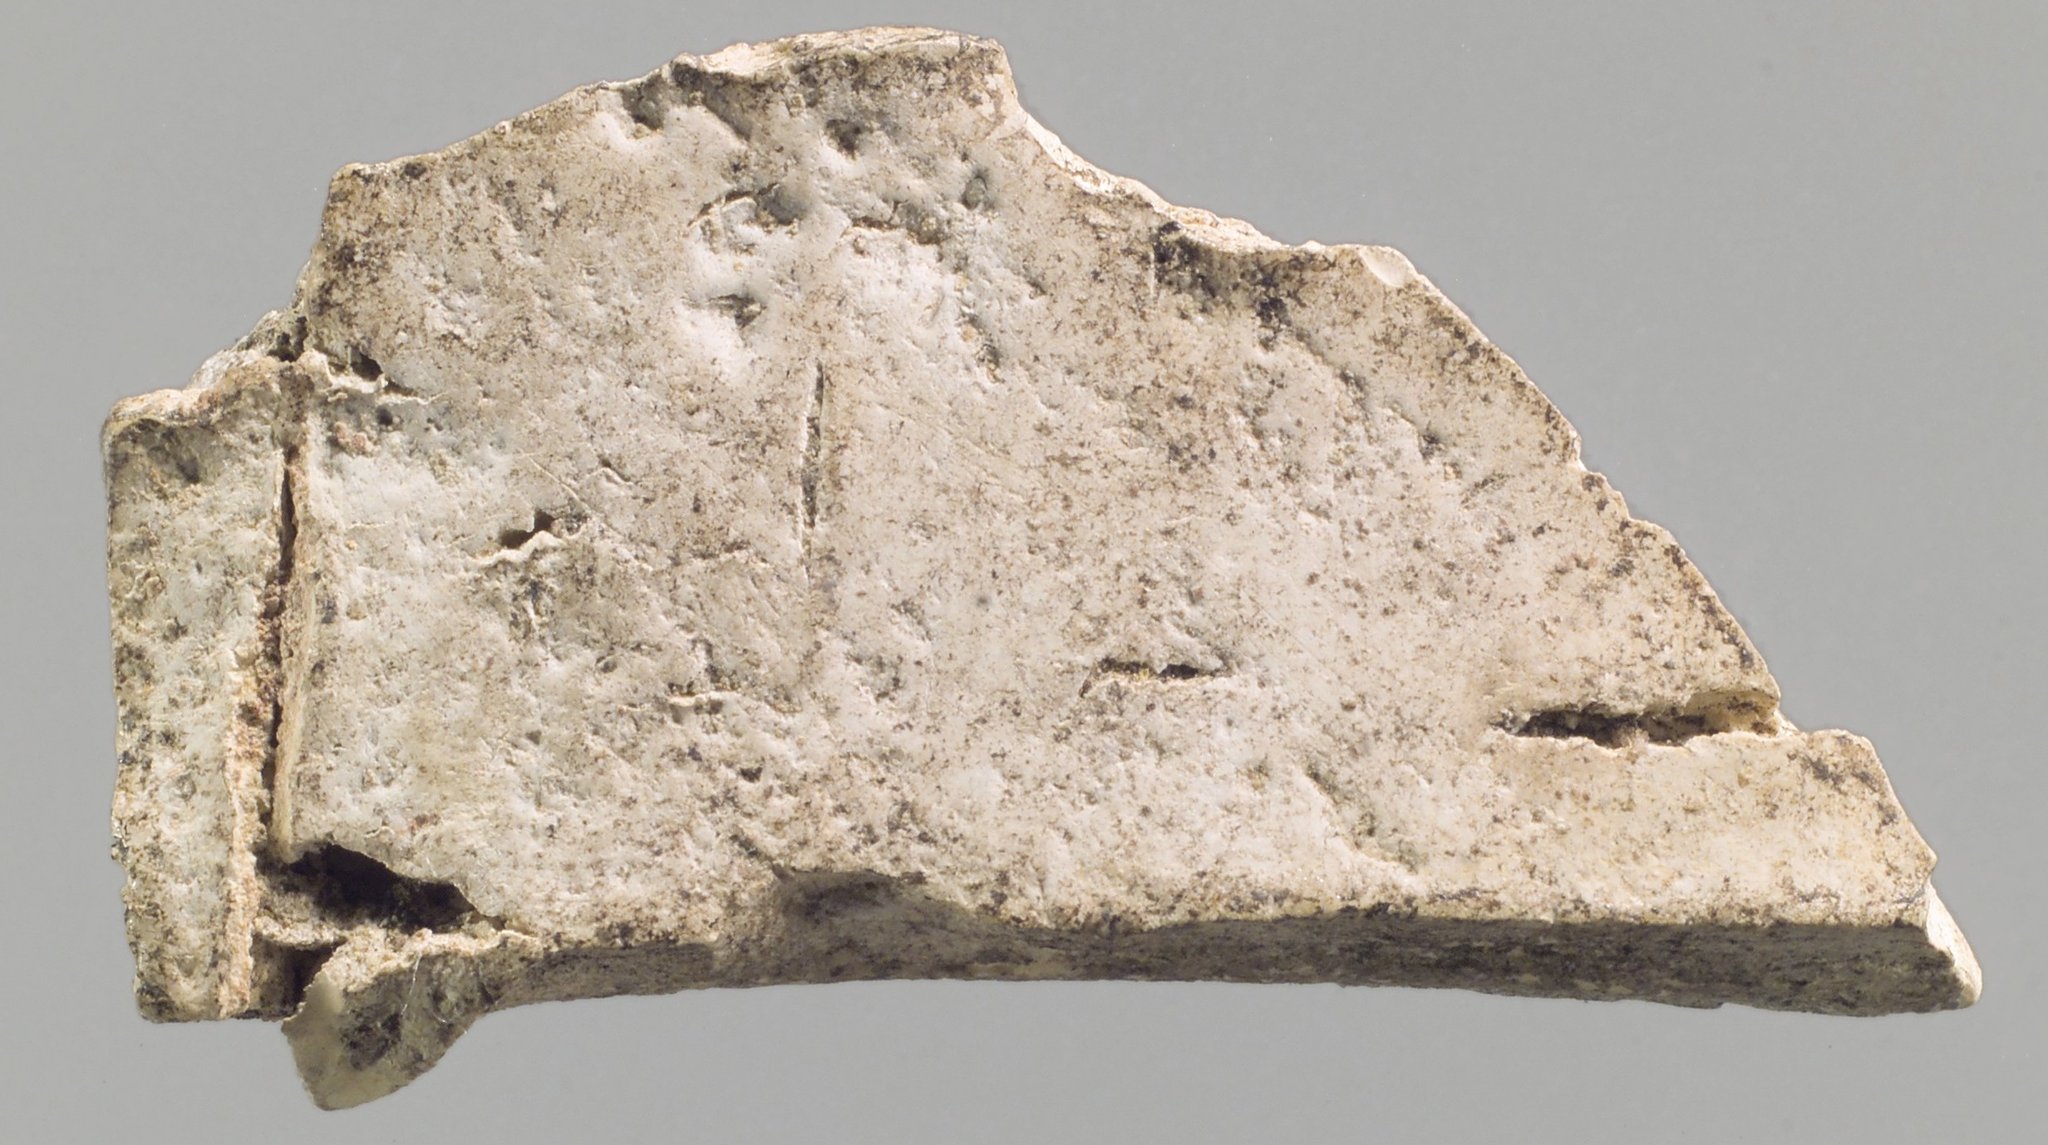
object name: plaque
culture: assyrian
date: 1800-1701 BCE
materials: ivory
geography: anatolia